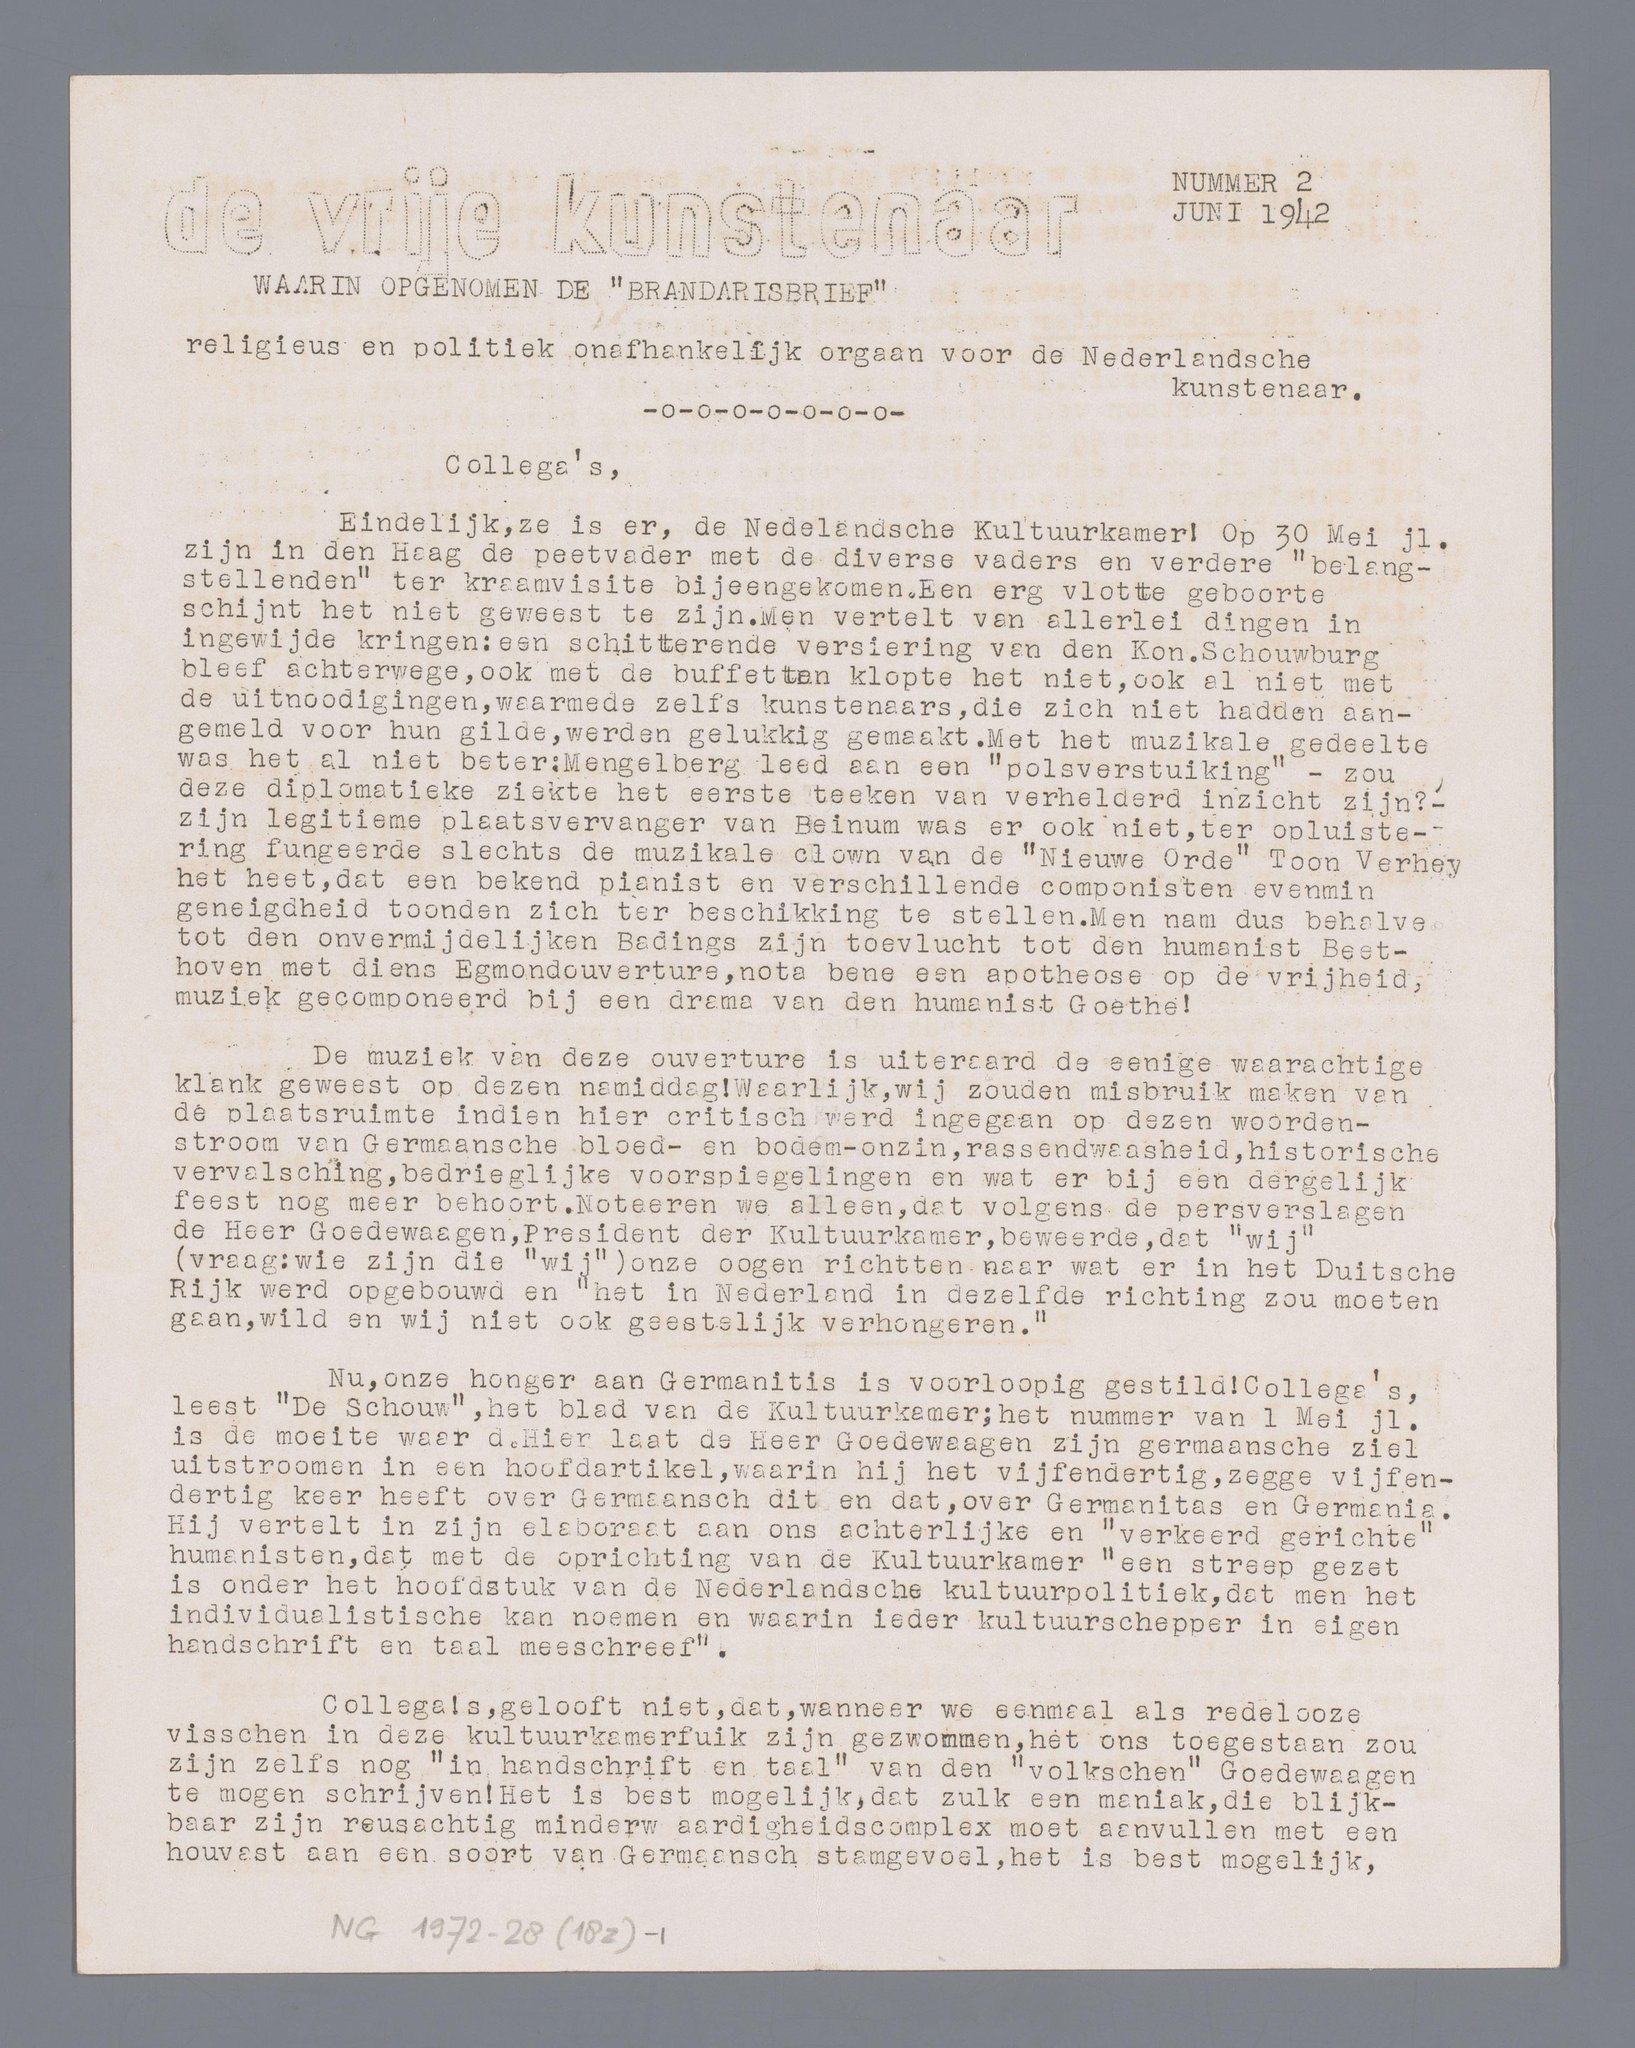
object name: magazine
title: De Vrije Kunstenaar; religieus en politiek onafhankelijk orgaan voor de Nederlandsche Kunstenaars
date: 1906-1942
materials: paper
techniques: mimeography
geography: amsterdam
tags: netherlands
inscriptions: date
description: Nummer van 'De Vrije Kunstenaar', 9 genummerde pp. Opschrift: 'Collega's'. Gedateerd: boven.